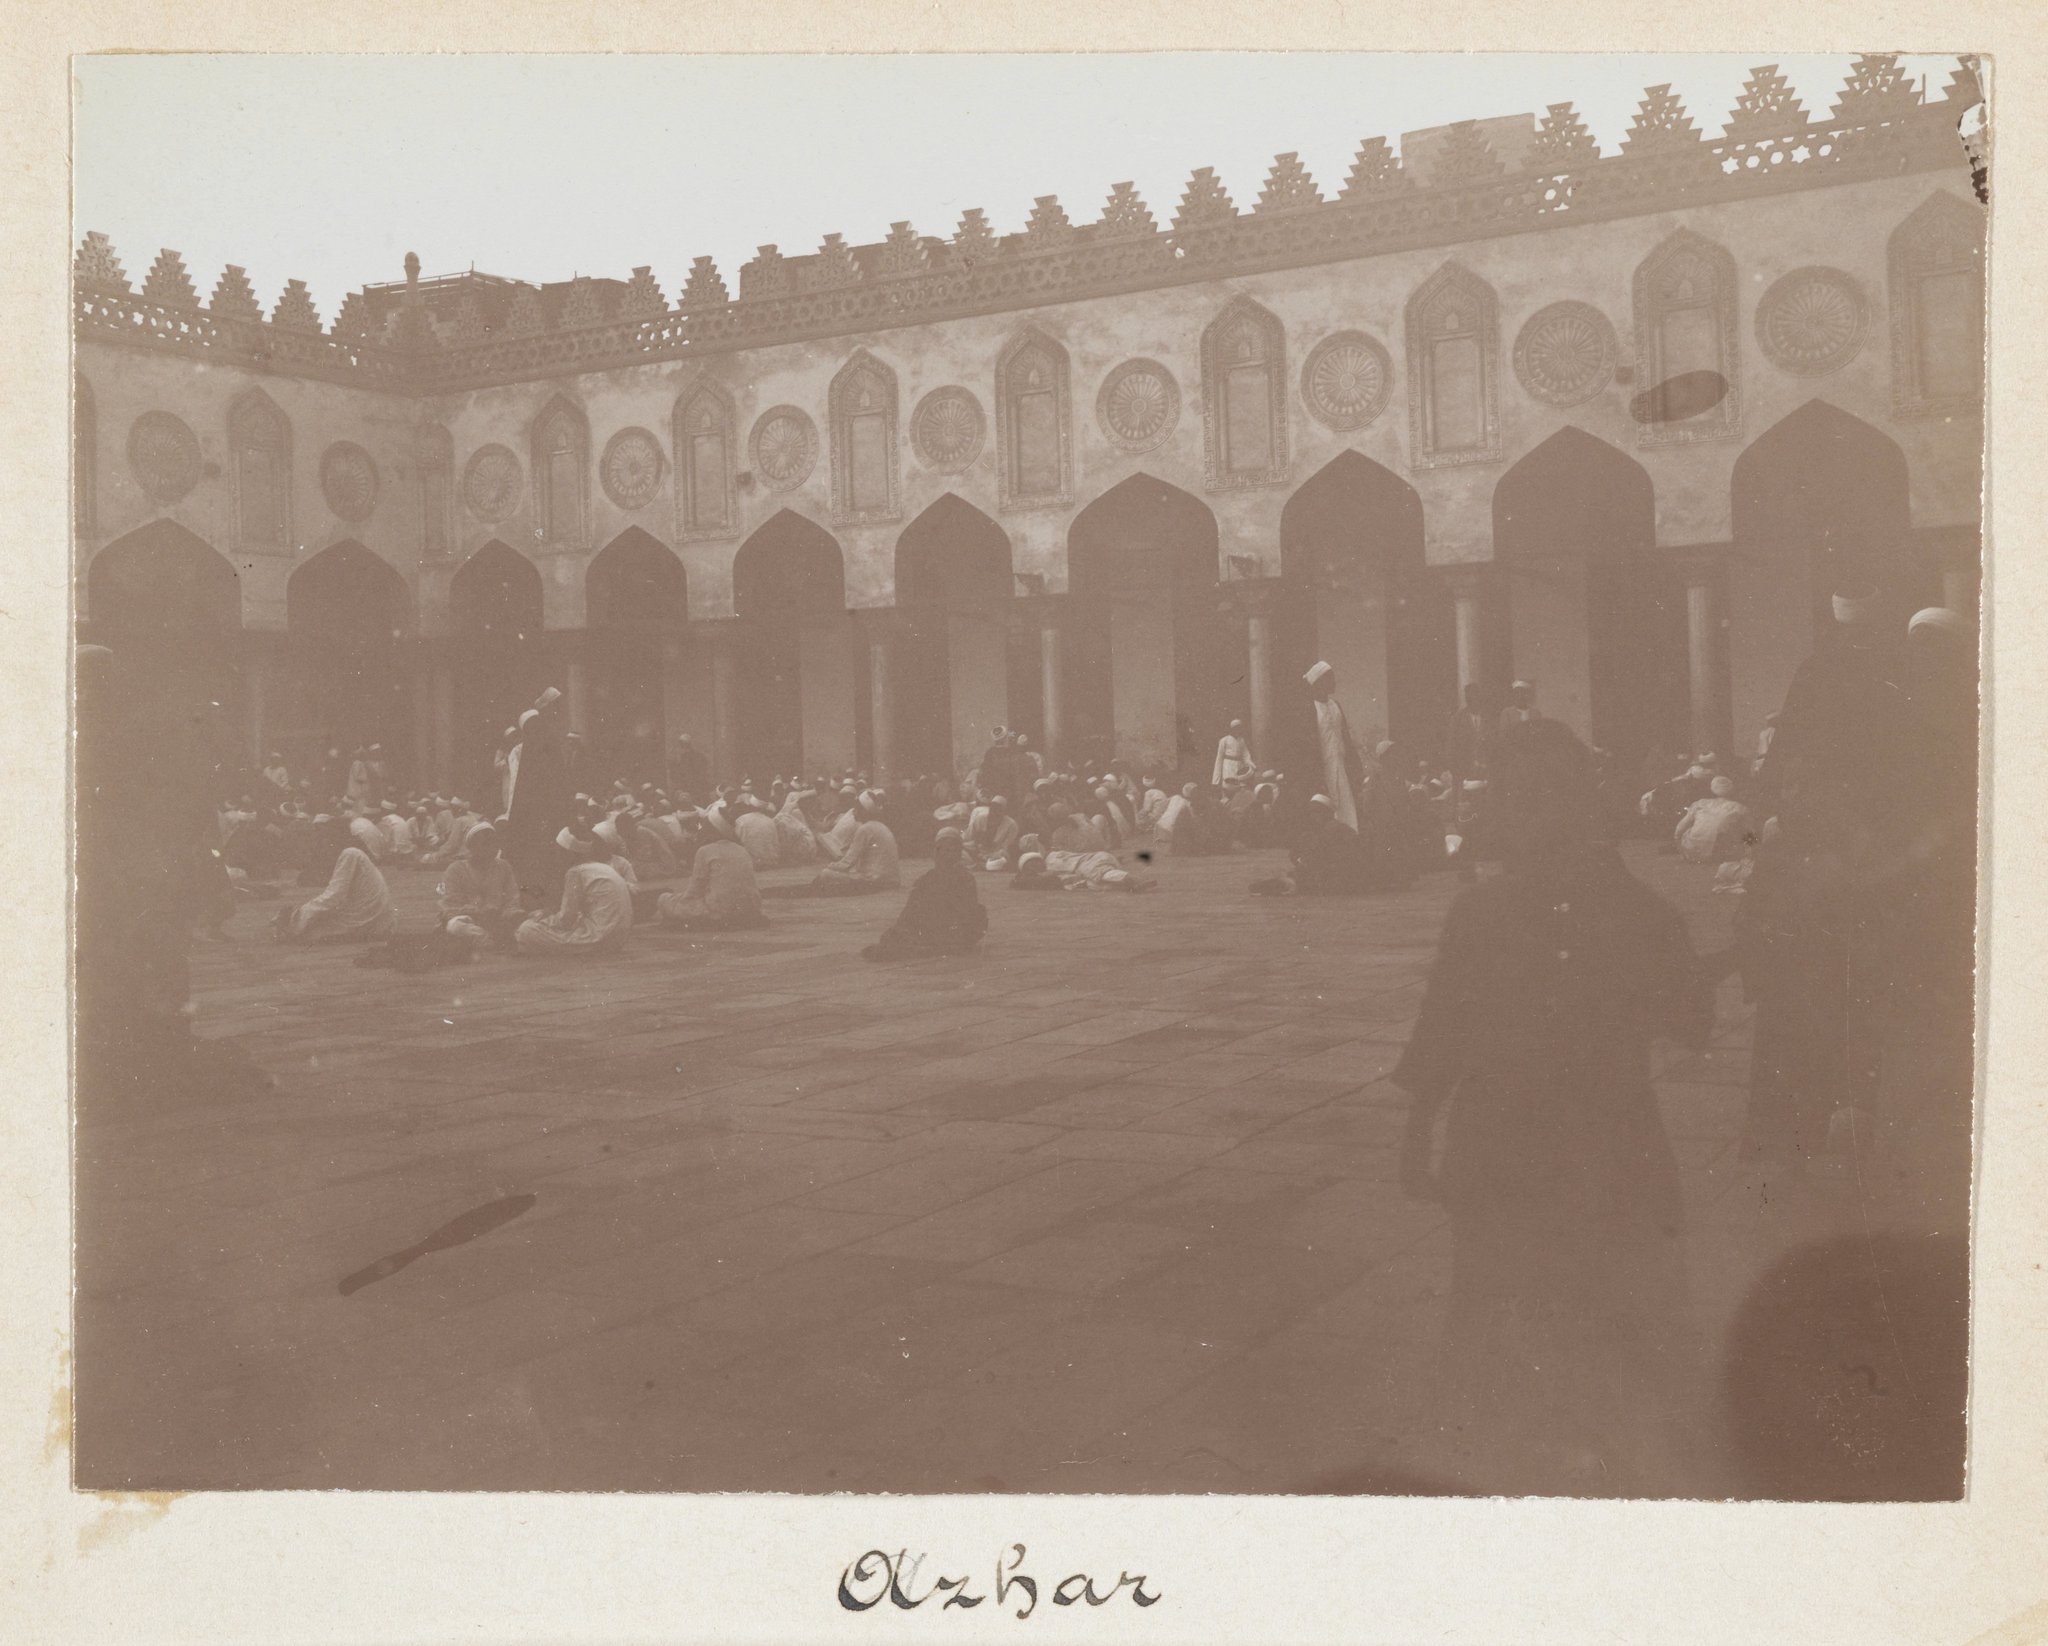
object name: page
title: Theologiestudenten in de Al-Azhar-moskee in Caïro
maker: johannes lodewijk heldring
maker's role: fotograaf, predikant, schrijver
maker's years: 1852-1923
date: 1898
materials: paper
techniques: collodion silver print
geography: cairo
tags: temple, shrine ~ islam, mohammedanism, student